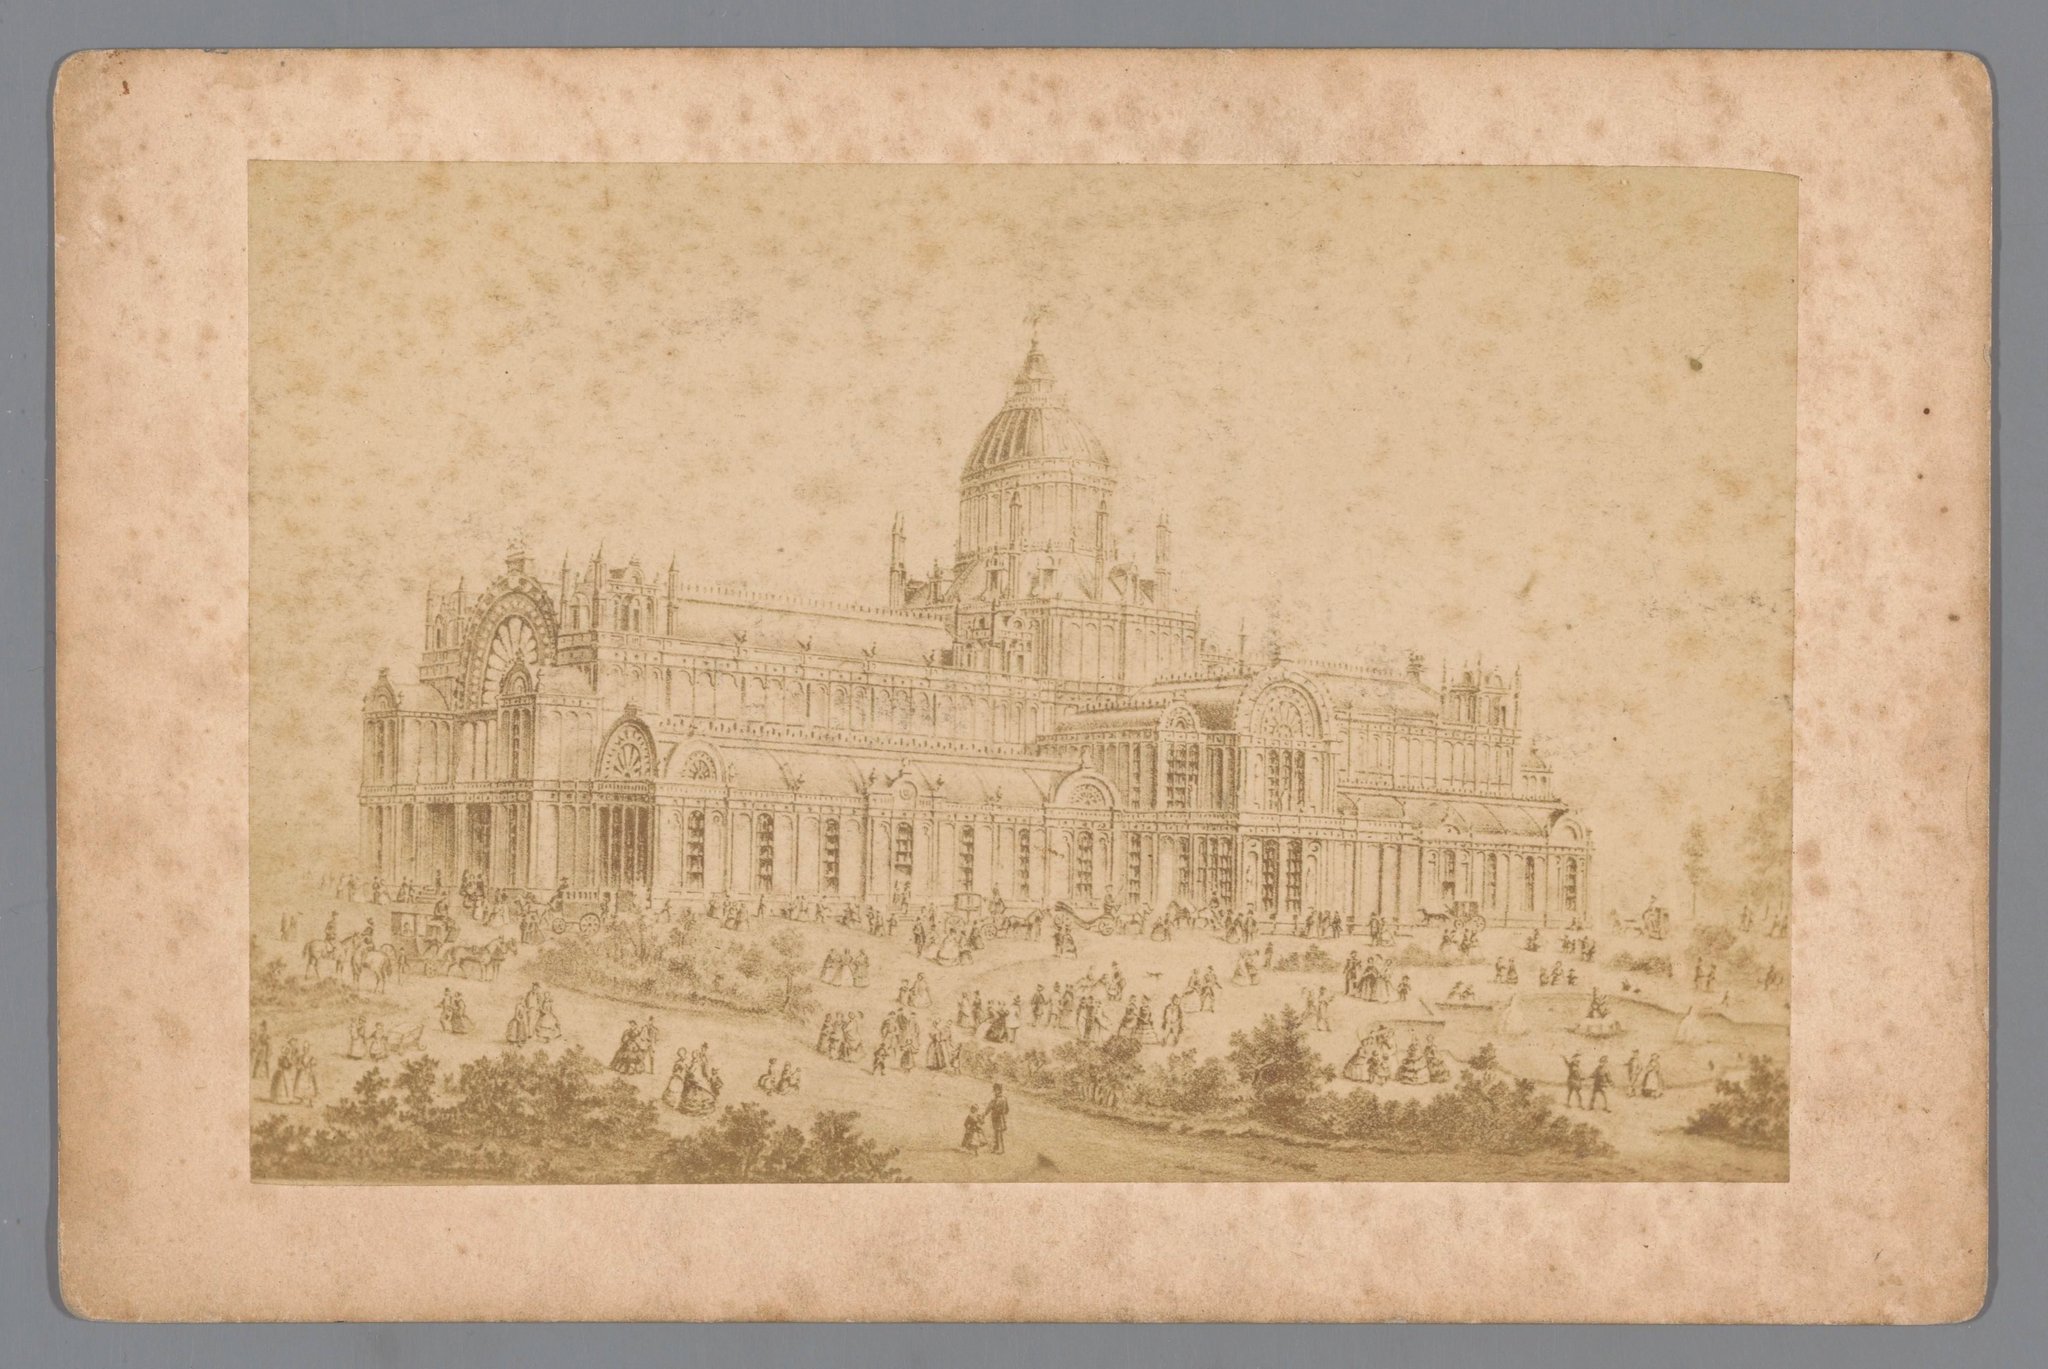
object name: photograph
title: Fotoreproductie van gezicht op het Paleis voor Volksvlijt te Amsterdam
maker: Anonymous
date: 1864-1890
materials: cardboard, photographic support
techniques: albumen print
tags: palace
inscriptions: inscription: ‘Paleis voor Volksvlijt’